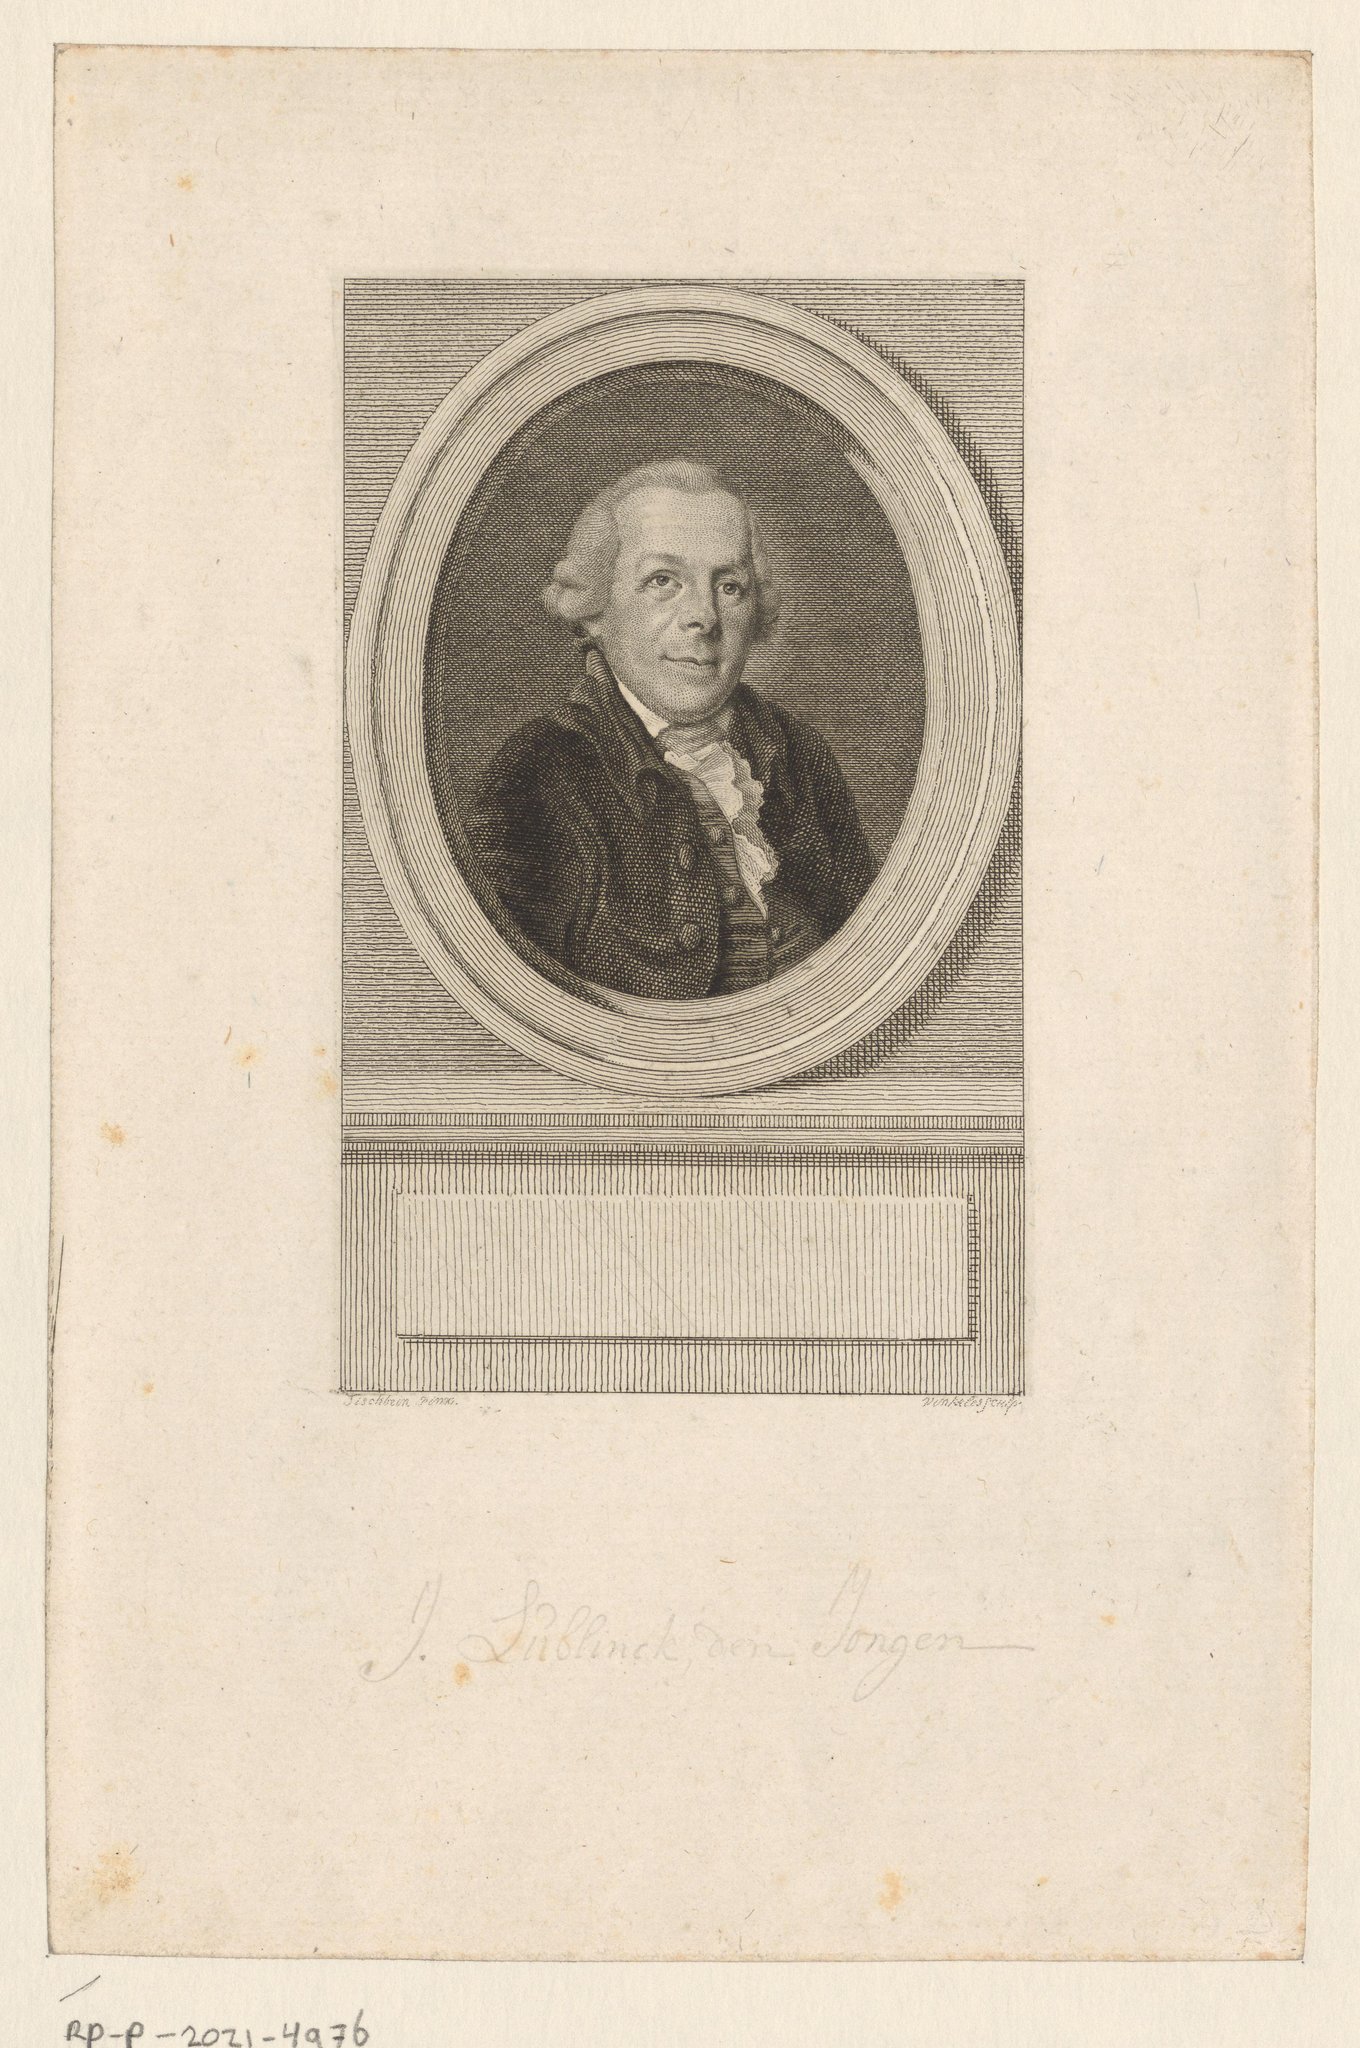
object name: print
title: Portret van Johannes Lublink de Jonge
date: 1776-1816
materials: paper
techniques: etching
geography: amsterdam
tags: utrecht, johannes lublink (de jonge), ornament ~ medallion, historical persons, portrait of a writer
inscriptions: collector's mark: Lugt 240